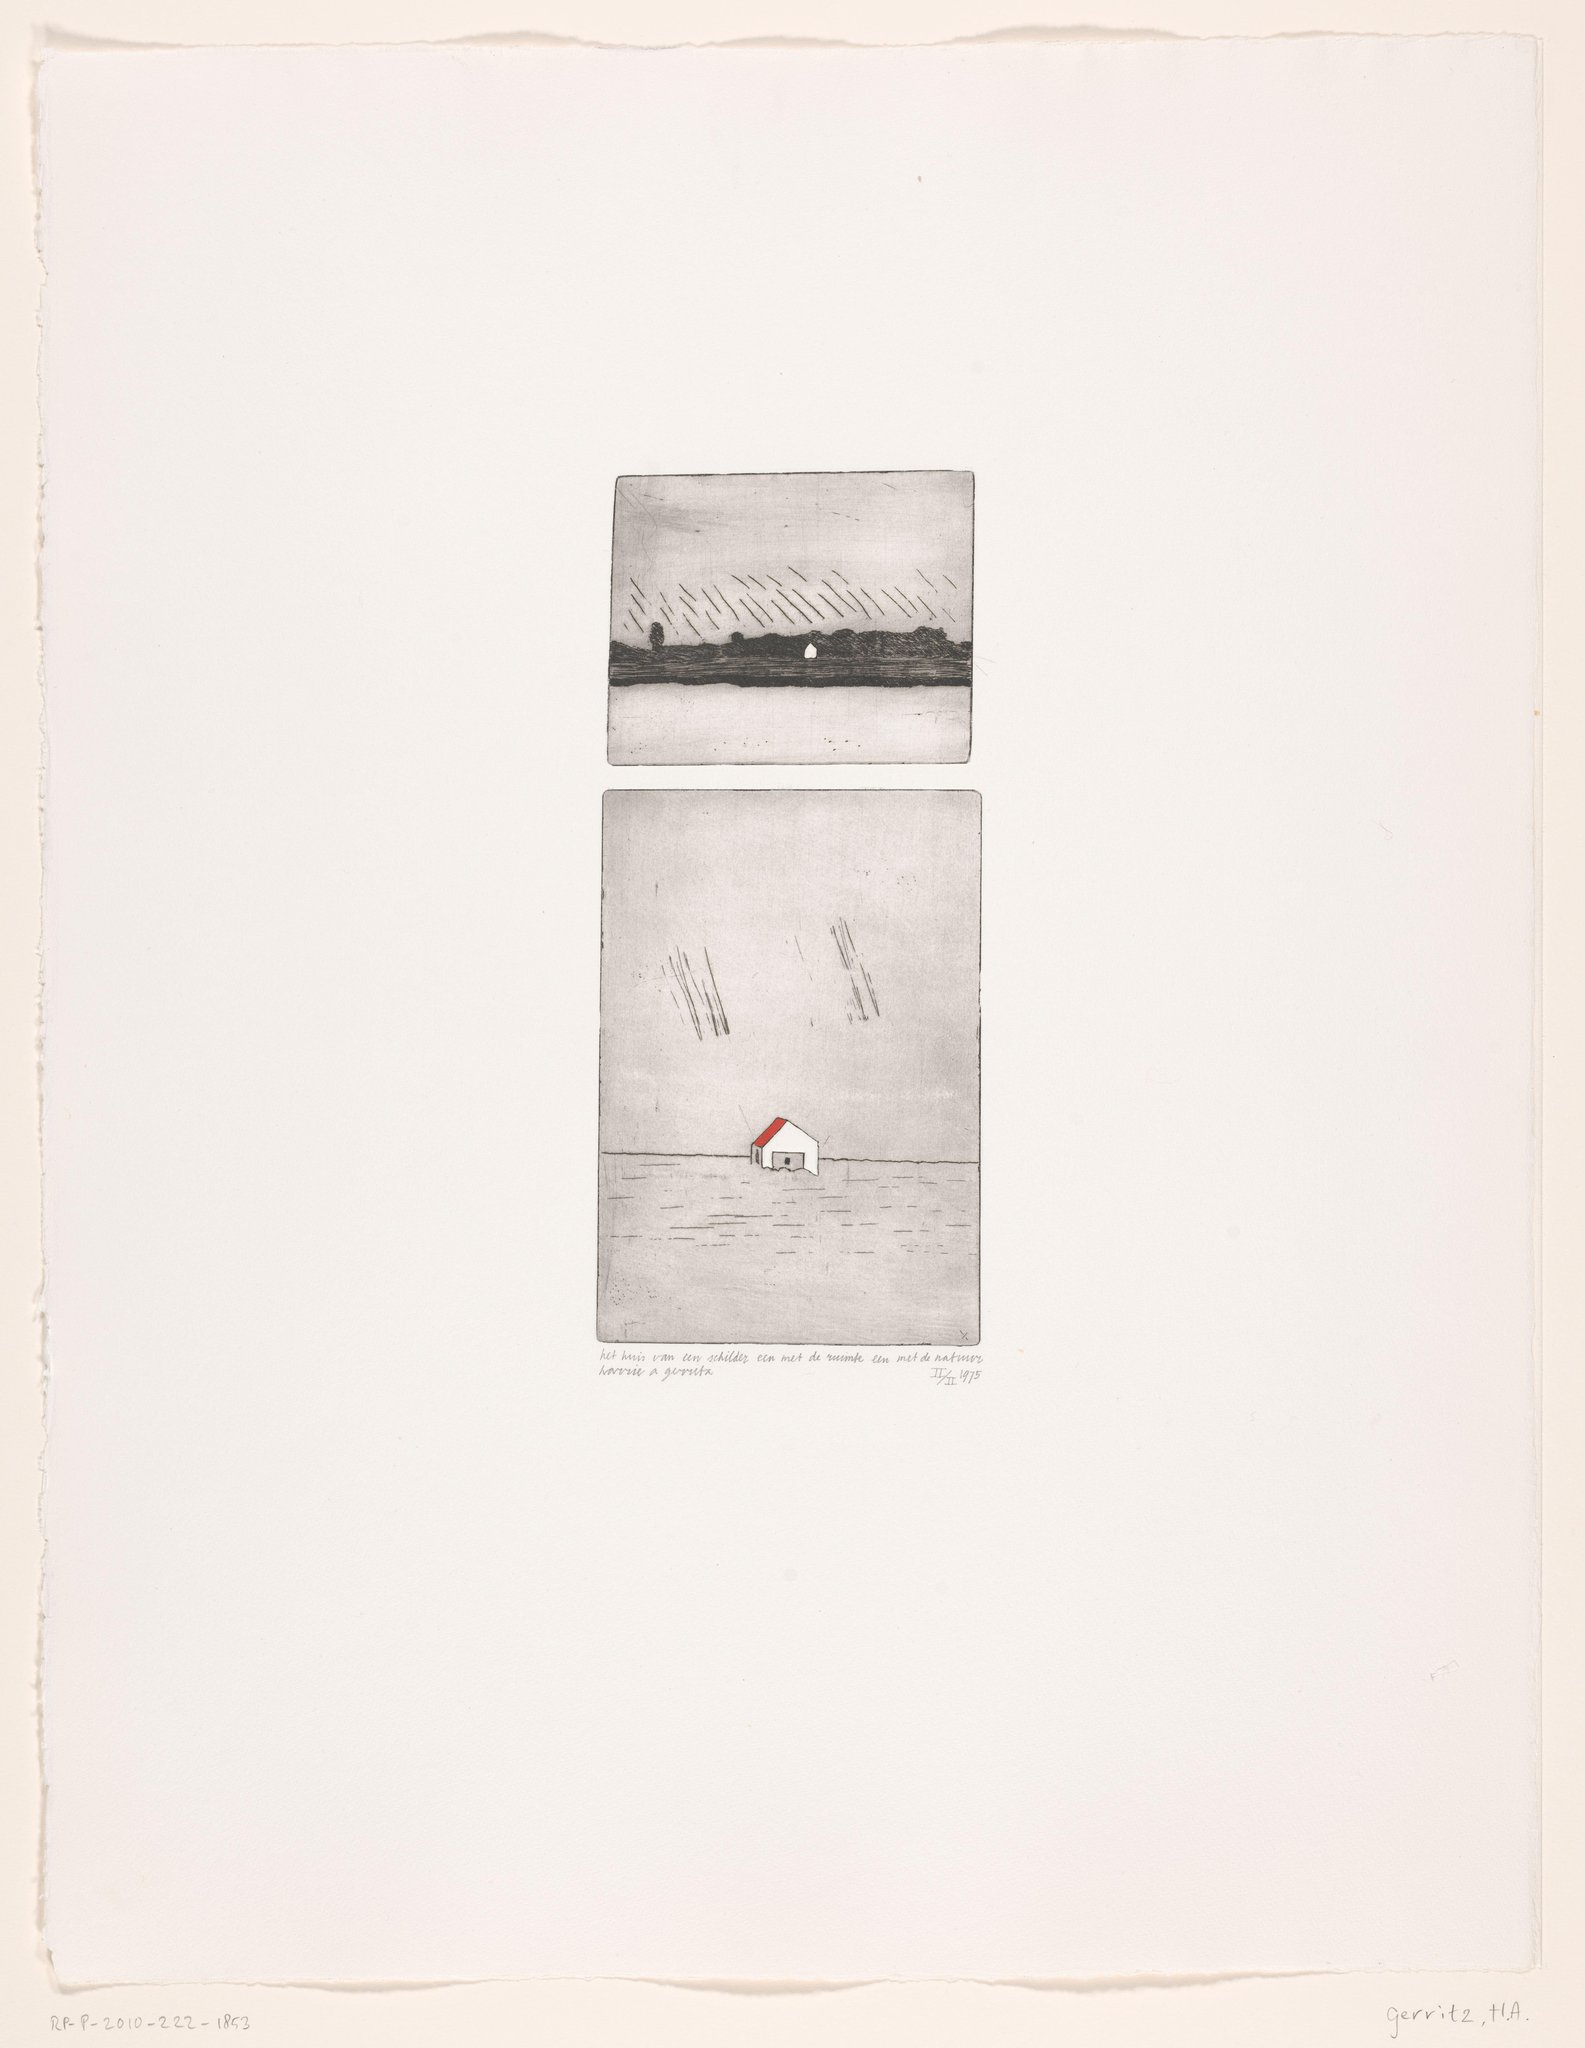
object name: print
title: Het huis van een schilder een met de ruimte een met de natuur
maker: harrie a. gerritz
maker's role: draughtsman, painter, print maker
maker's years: 1940-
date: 1975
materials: paper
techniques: etching, hand coloring, intaglio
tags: landscapes in the temperate zone, rural housing, e.g. country-house, villa, cottage, rain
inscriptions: collector's mark: Lugt 2228, inscription: ‘PC’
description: Twee voorstellingen boven elkaar gedrukt van twee platen. Onder een huis met rood dak in een grijze omgeving. Boven een donker landschap met regen.